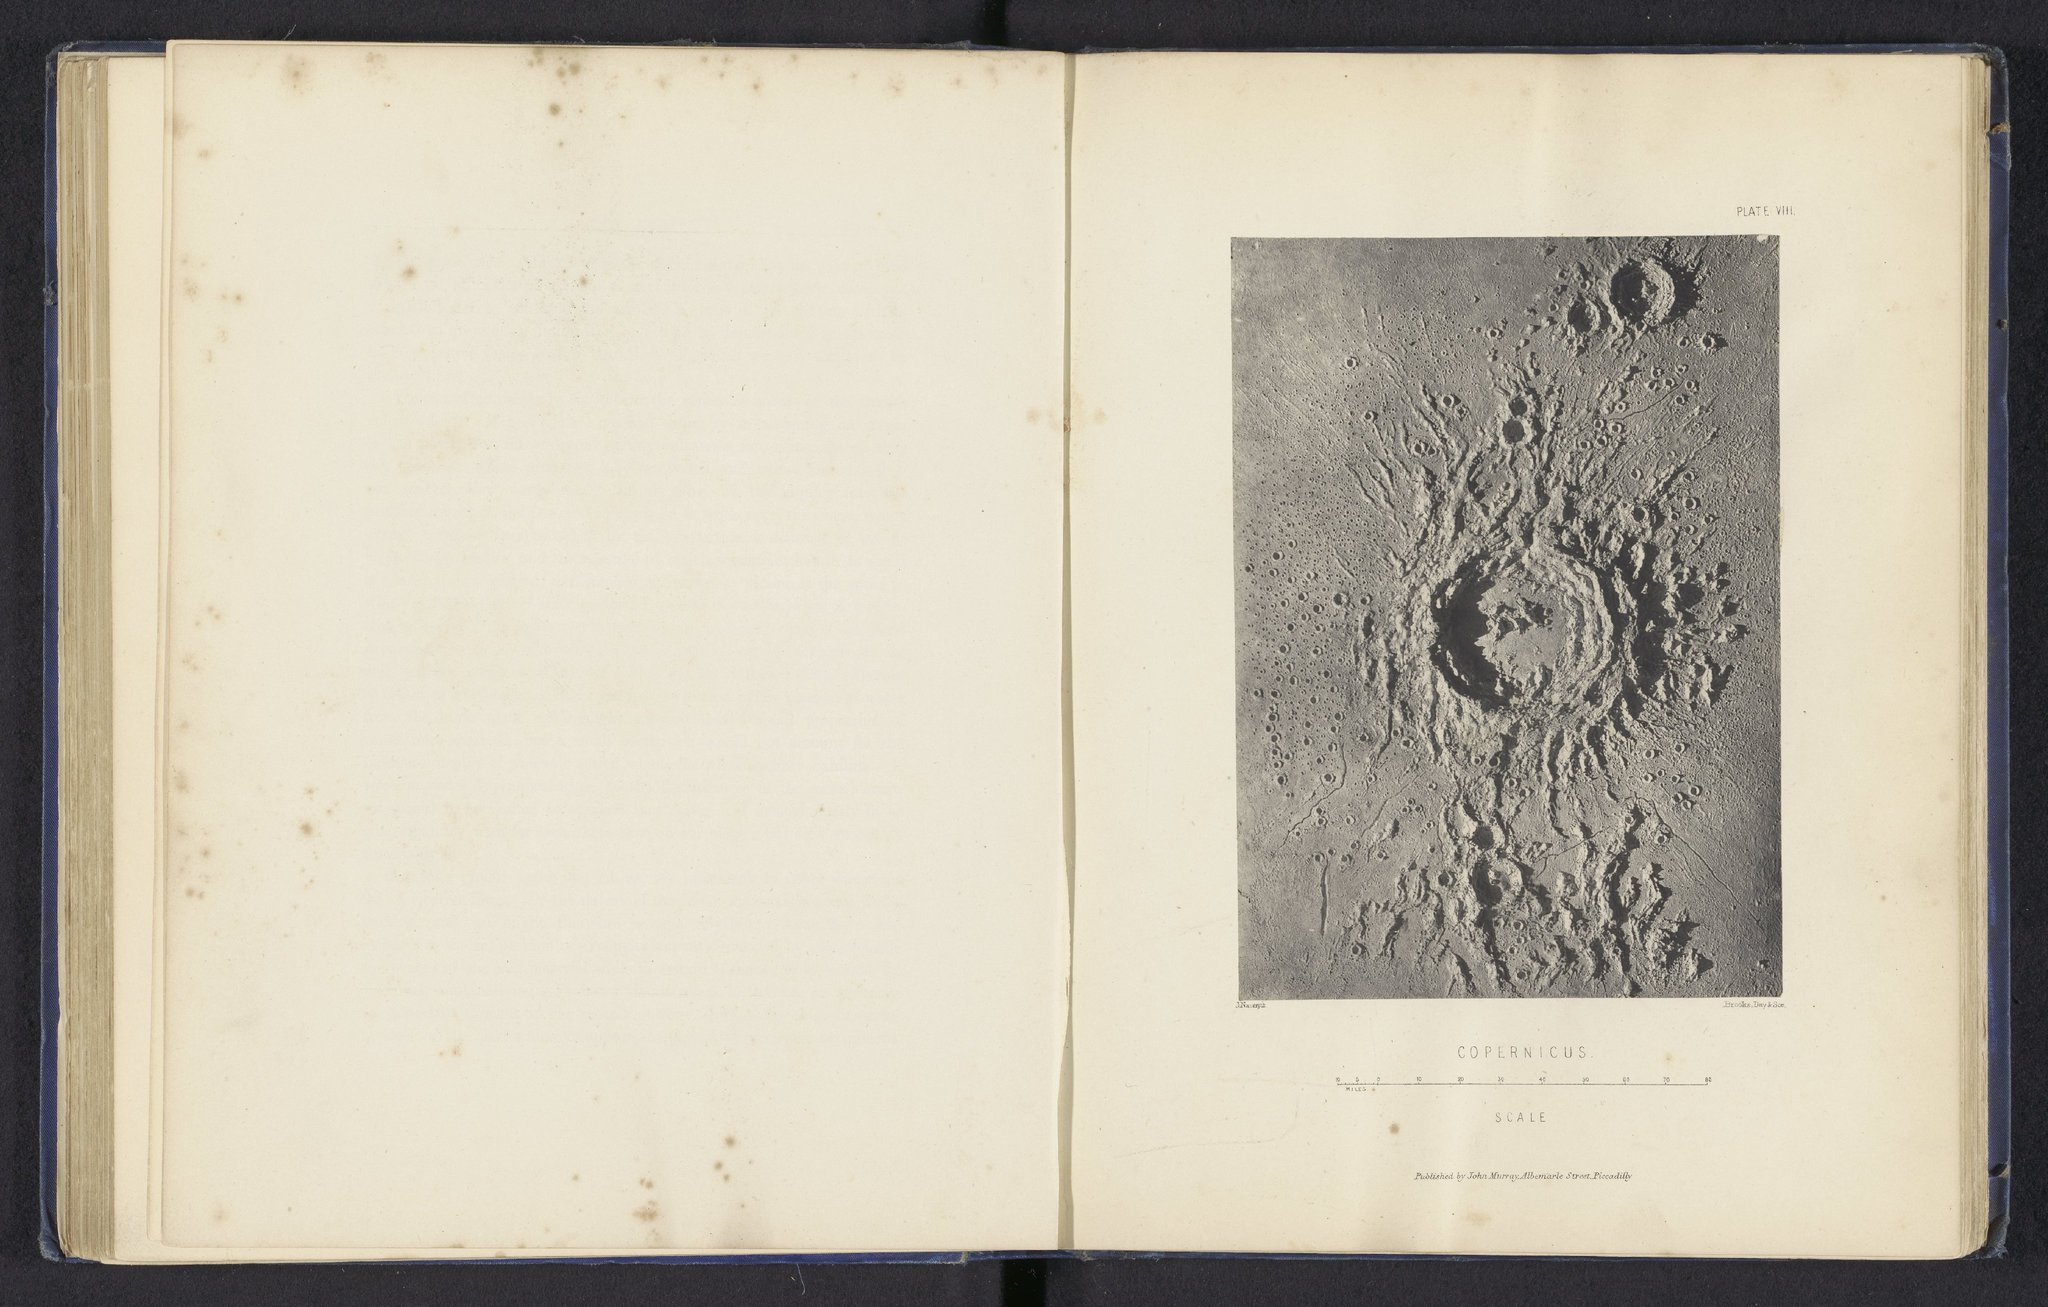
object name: photomechanical print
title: Copernicus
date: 1870-1873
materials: paper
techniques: woodburytype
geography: london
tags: surface of the moon, moon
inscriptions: inscription: ‘Scale’, name: ‘Published by John Murray, Albemarle Street Piccadilly.’, number: ‘Plate VIII.’